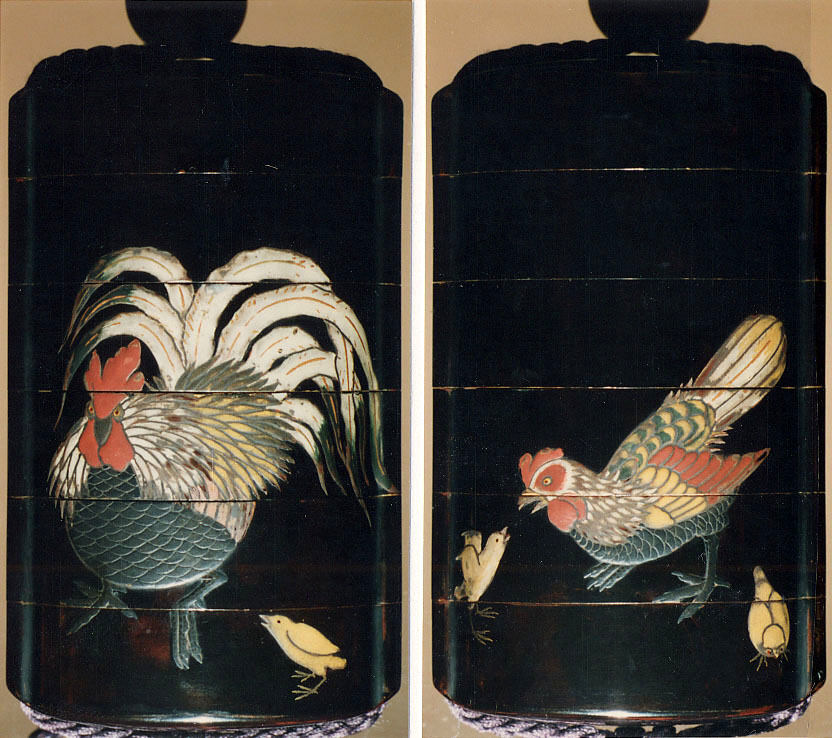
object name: inrō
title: Inrō with Rooster, Hen, and Chicks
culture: japanese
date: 1701-1900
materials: glass, lacquer, wood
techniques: carving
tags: chickens,roosters